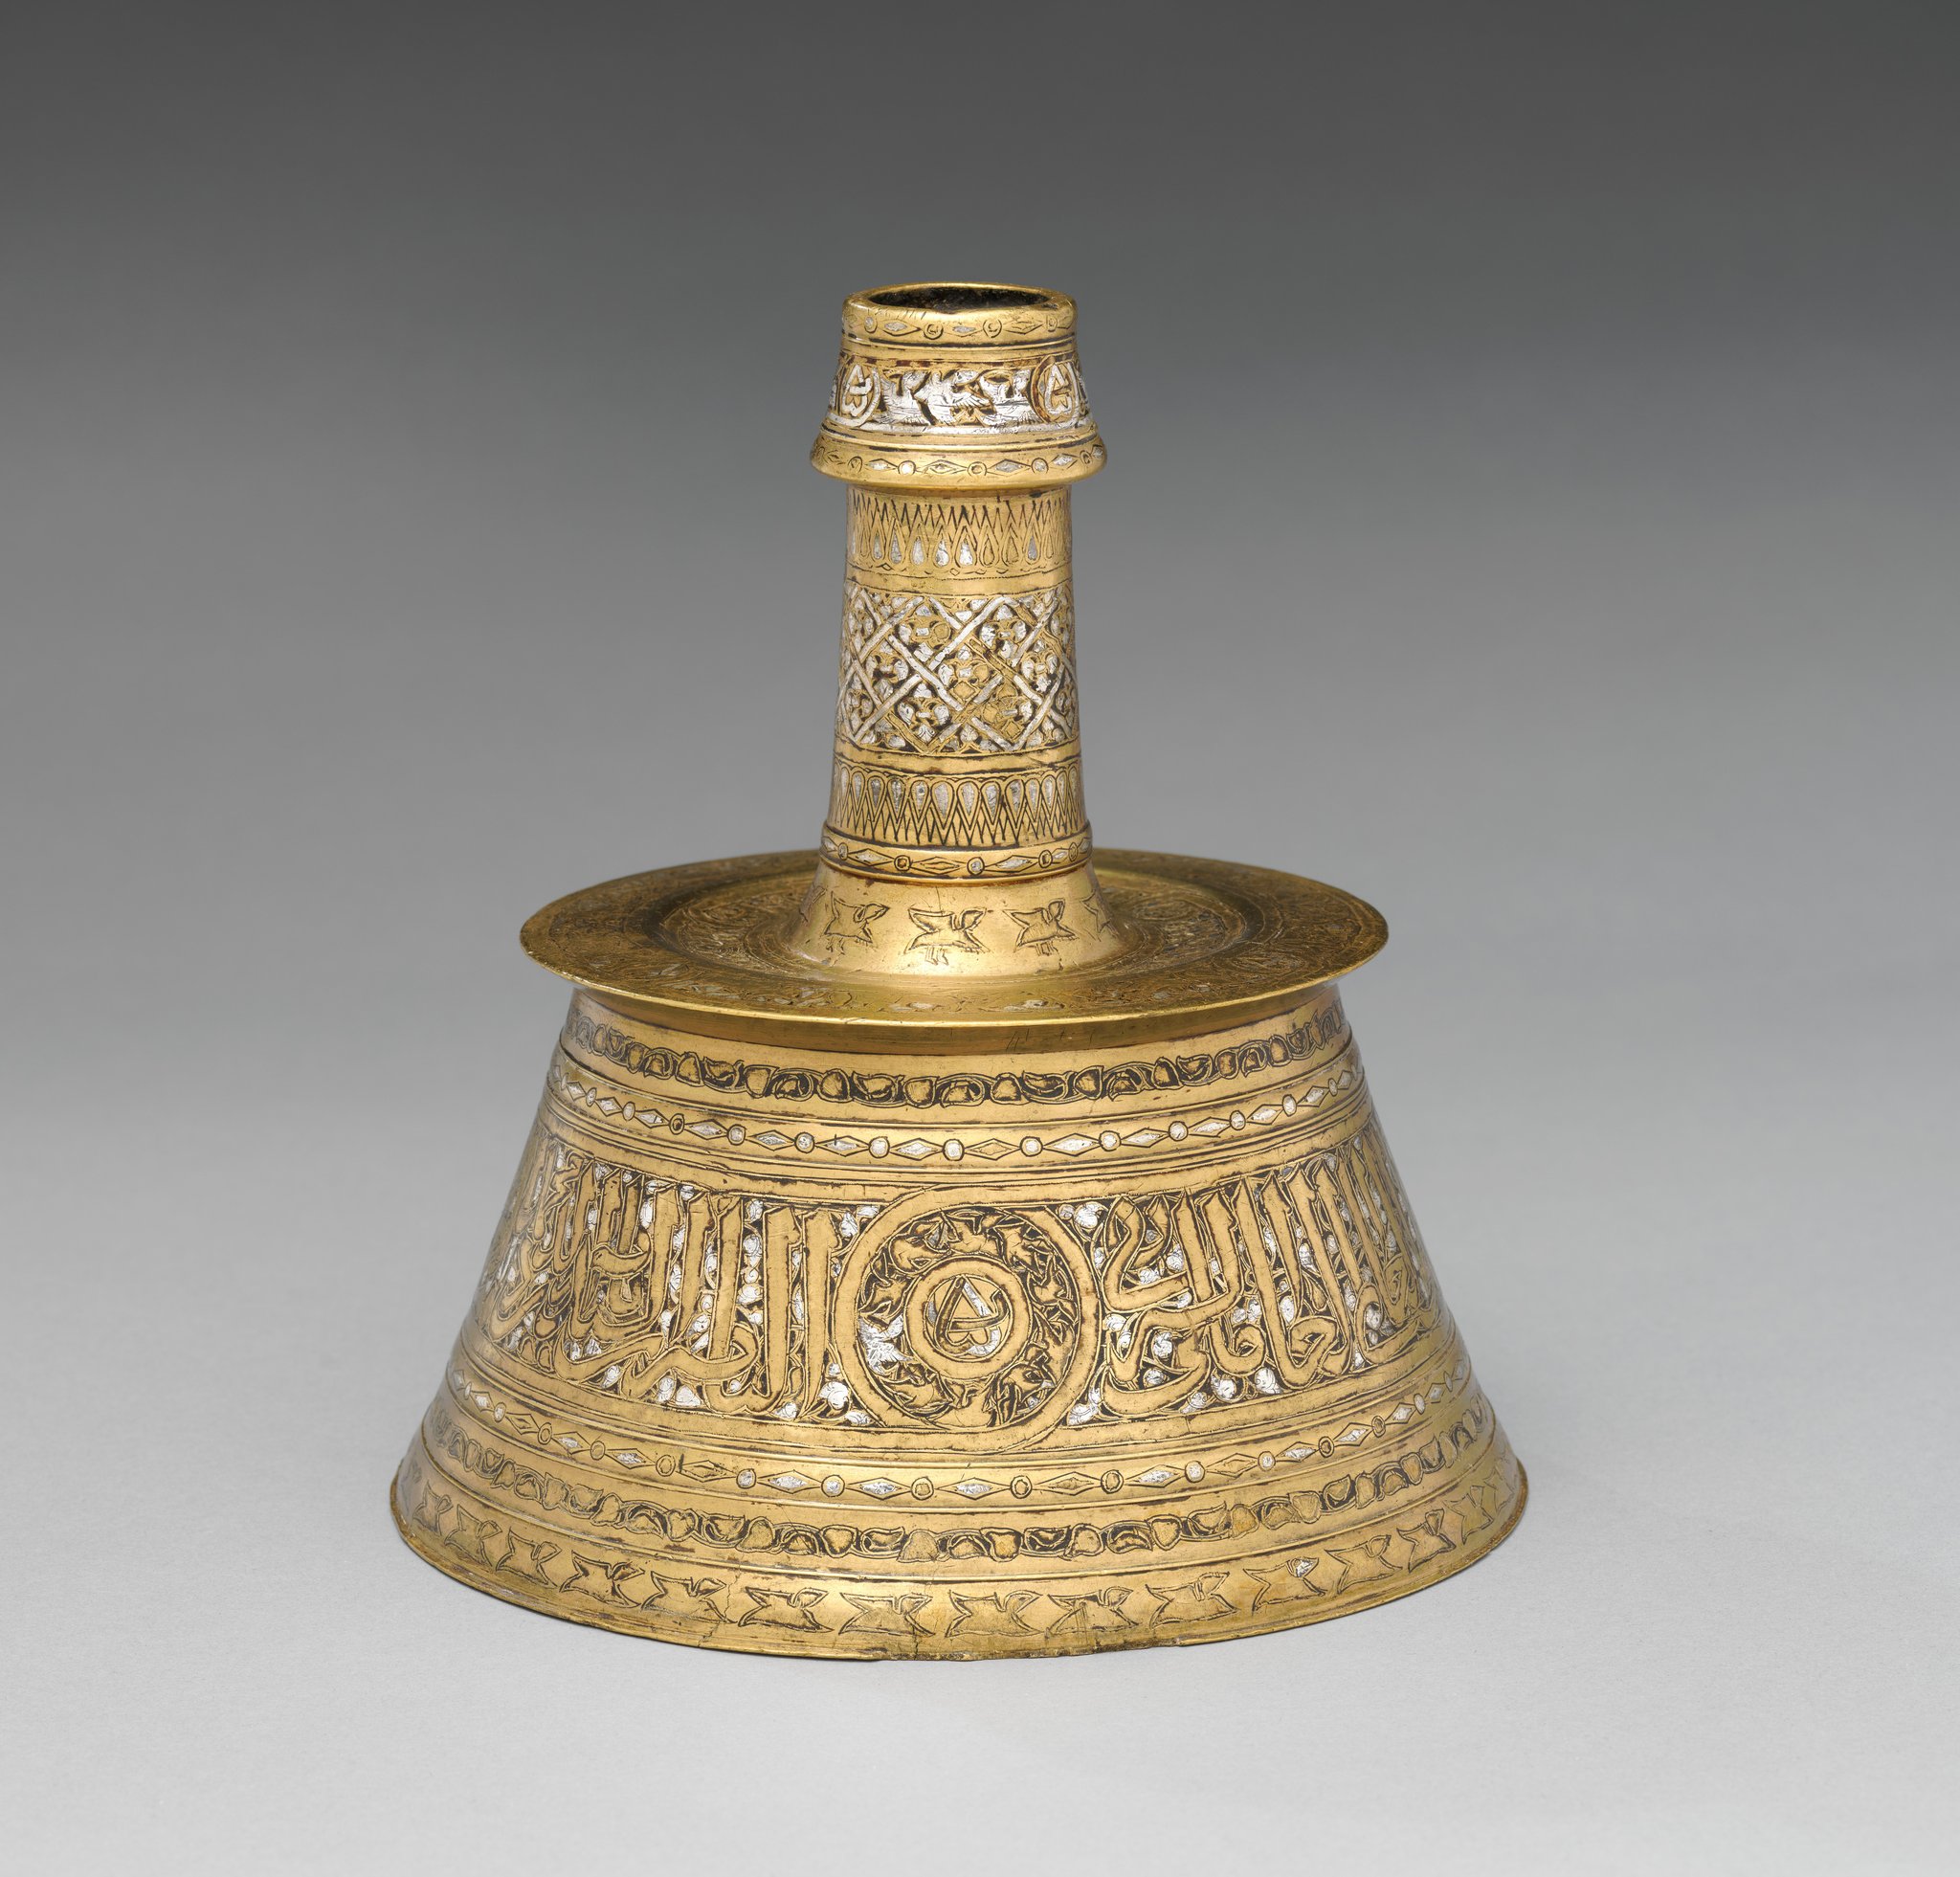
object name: candlestick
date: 1267-1333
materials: brass, silver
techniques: inlay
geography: egypt